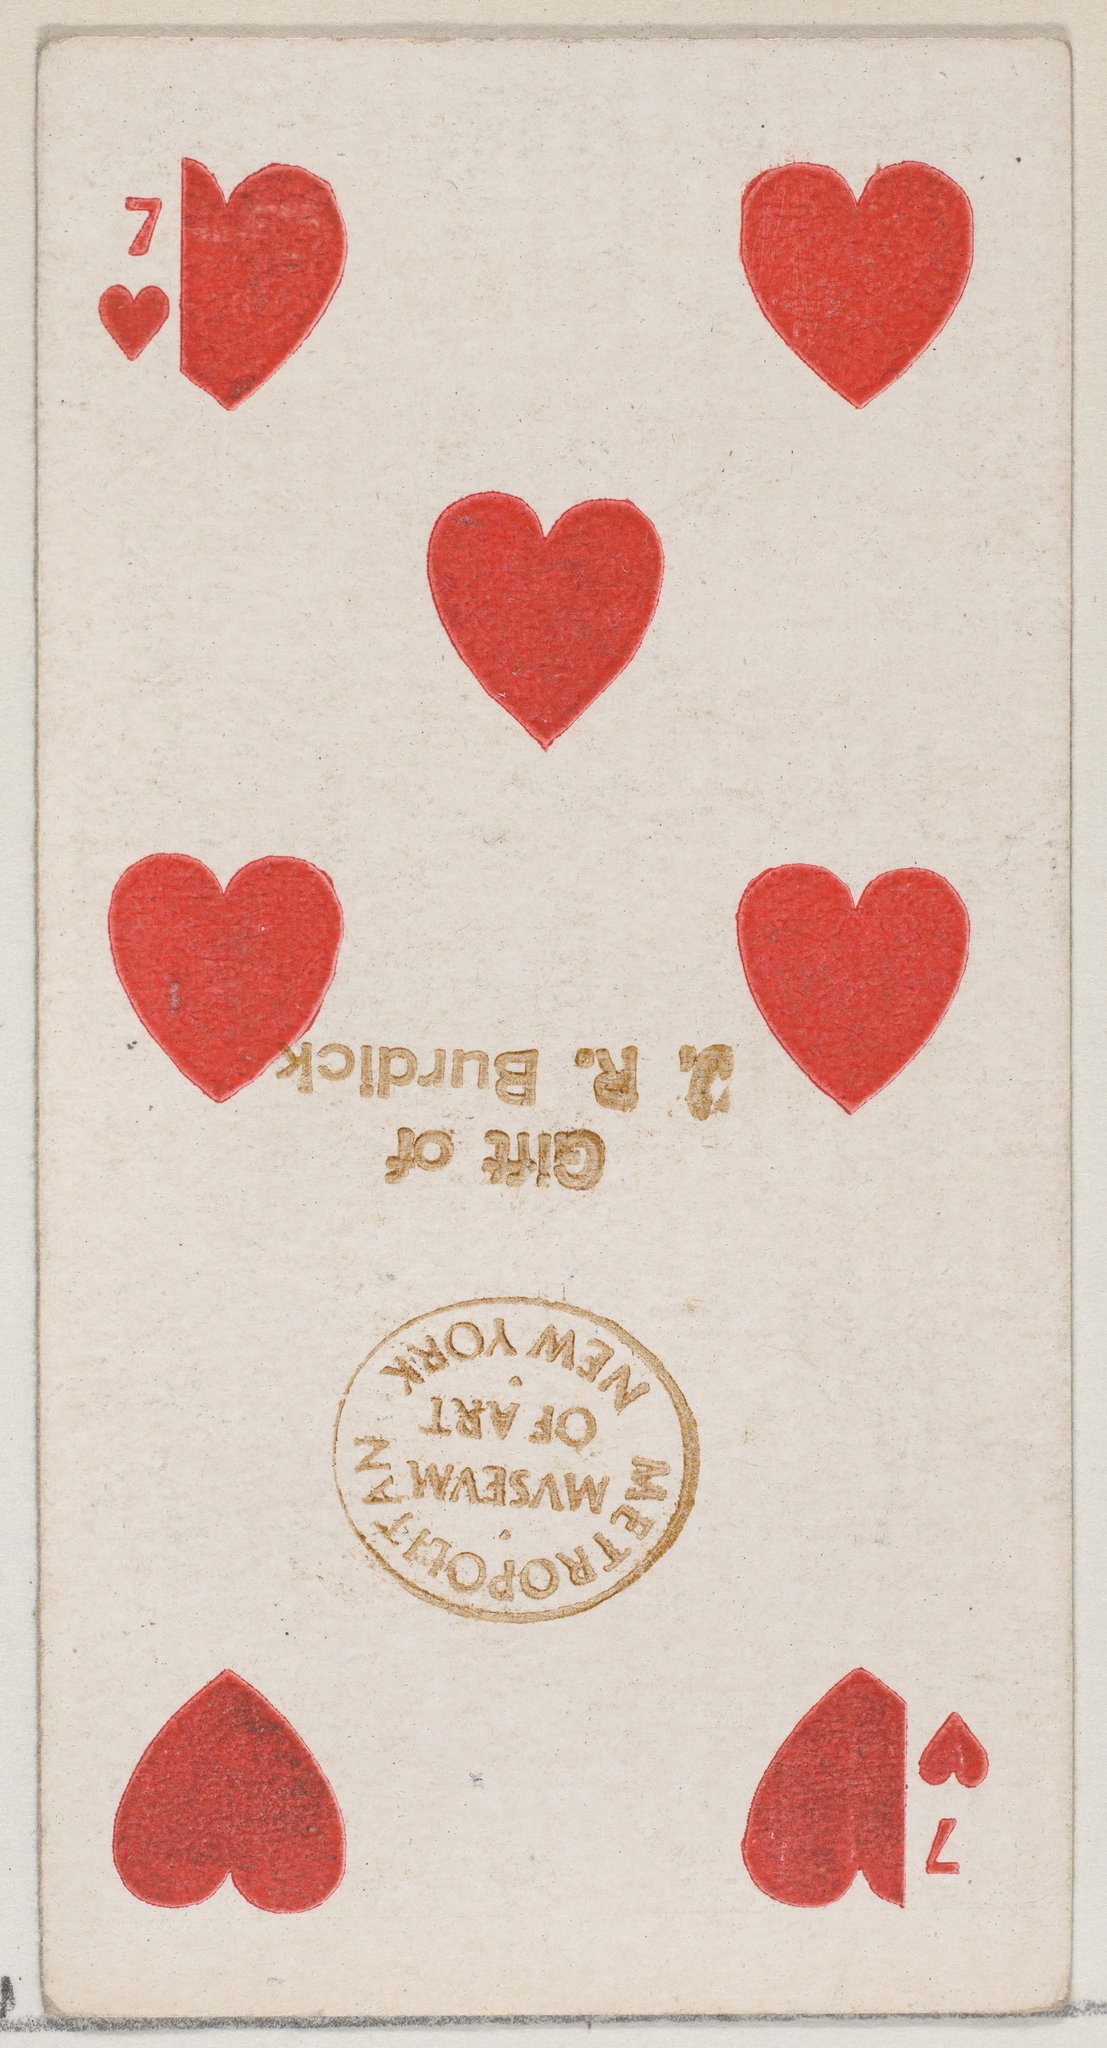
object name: print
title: Seven Hearts (red), from the Playing Cards series (N84) for Duke brand cigarettes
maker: w. duke, sons & co.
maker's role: publisher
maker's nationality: american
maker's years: 1870-1920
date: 1888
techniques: color lithograph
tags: playing cards